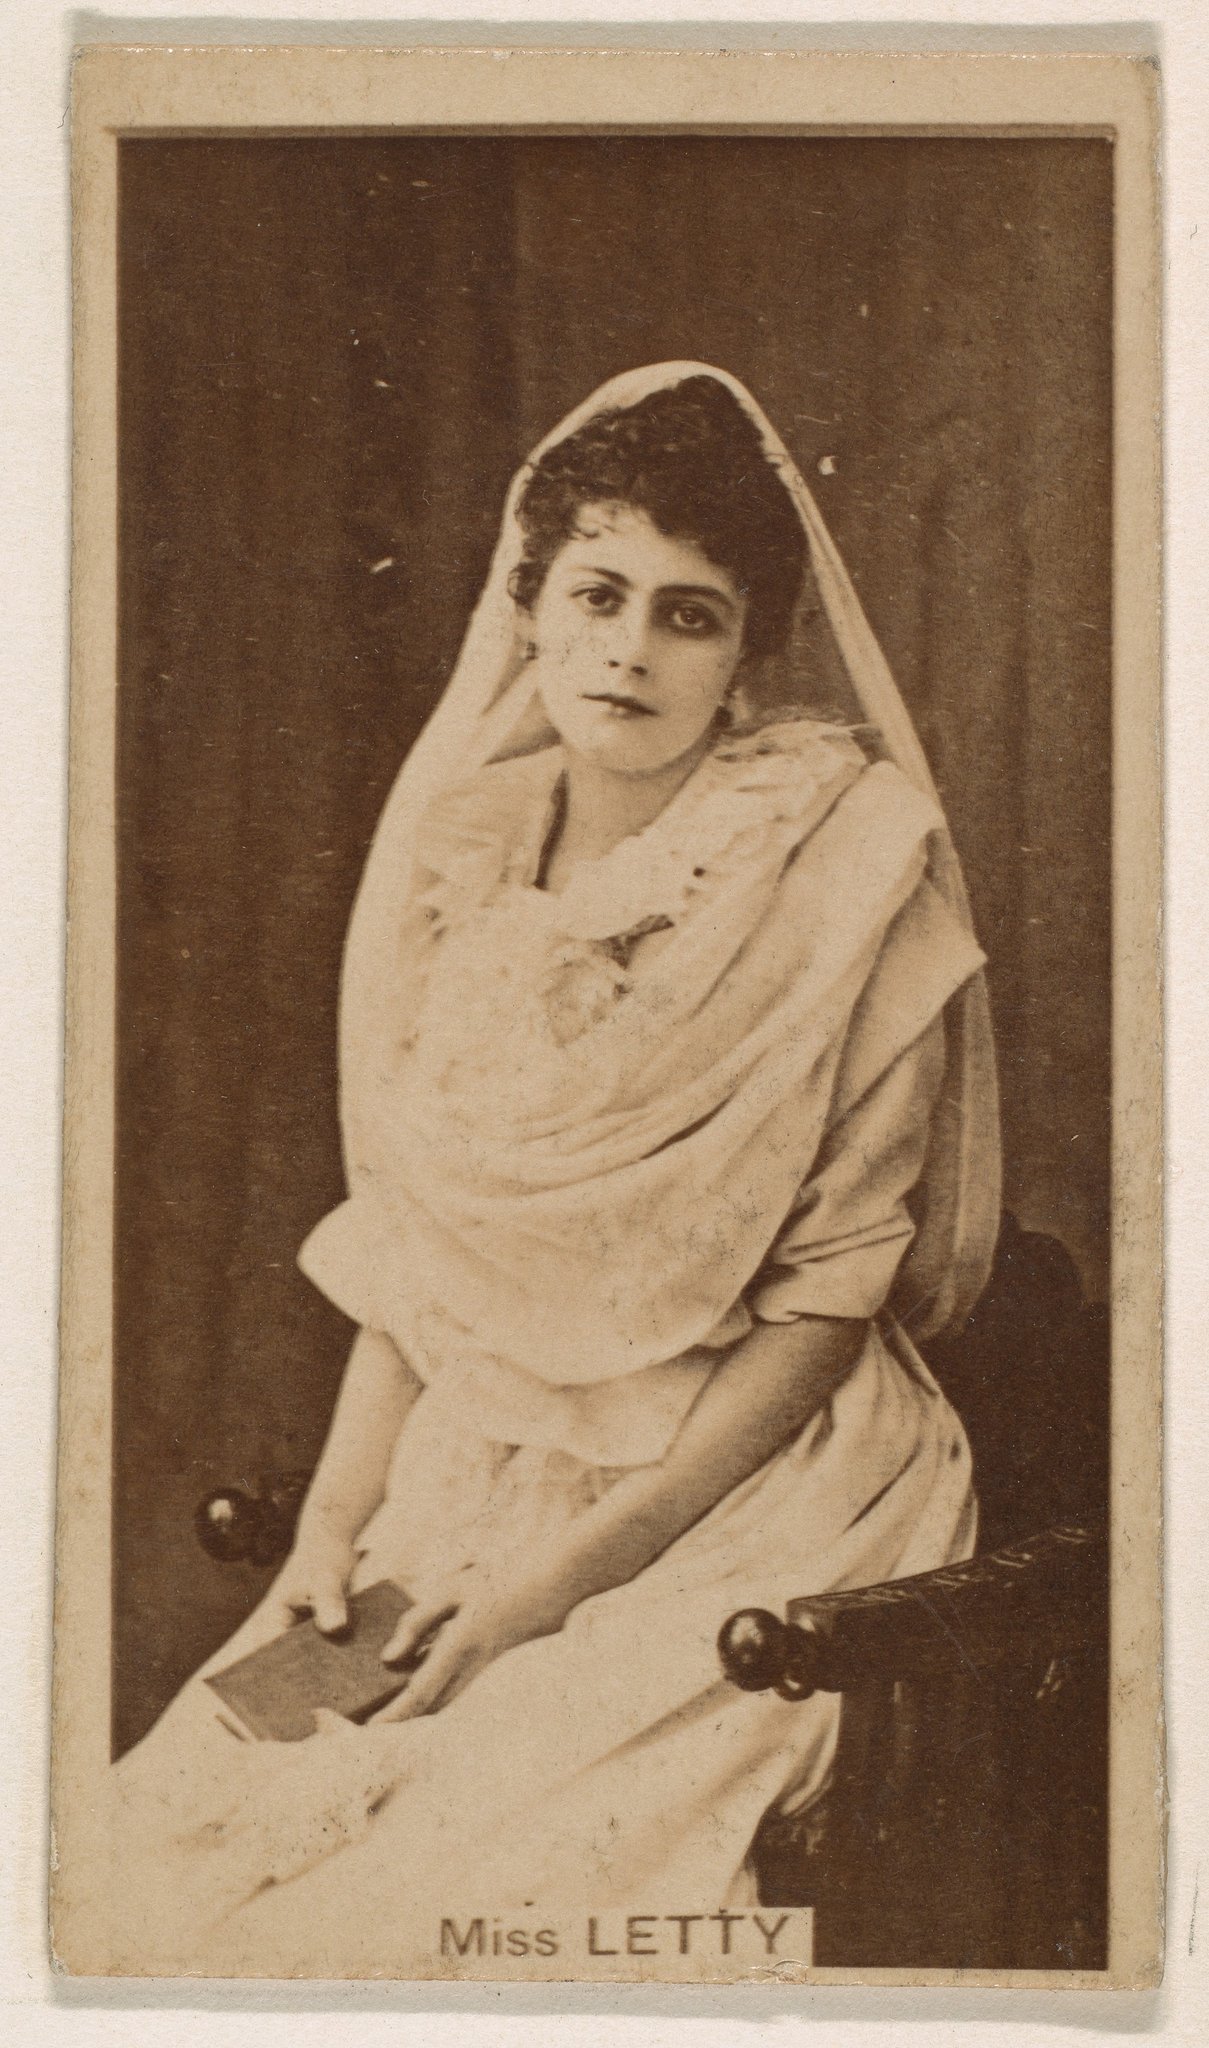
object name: photograph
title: Miss Letty, from the Actresses series (N245) issued by Kinney Brothers to promote Sweet Caporal Cigarettes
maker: kinney brothers tobacco company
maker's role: publisher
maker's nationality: american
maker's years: 1869-2011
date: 1890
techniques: albumen silver print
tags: portraits,women,actresses